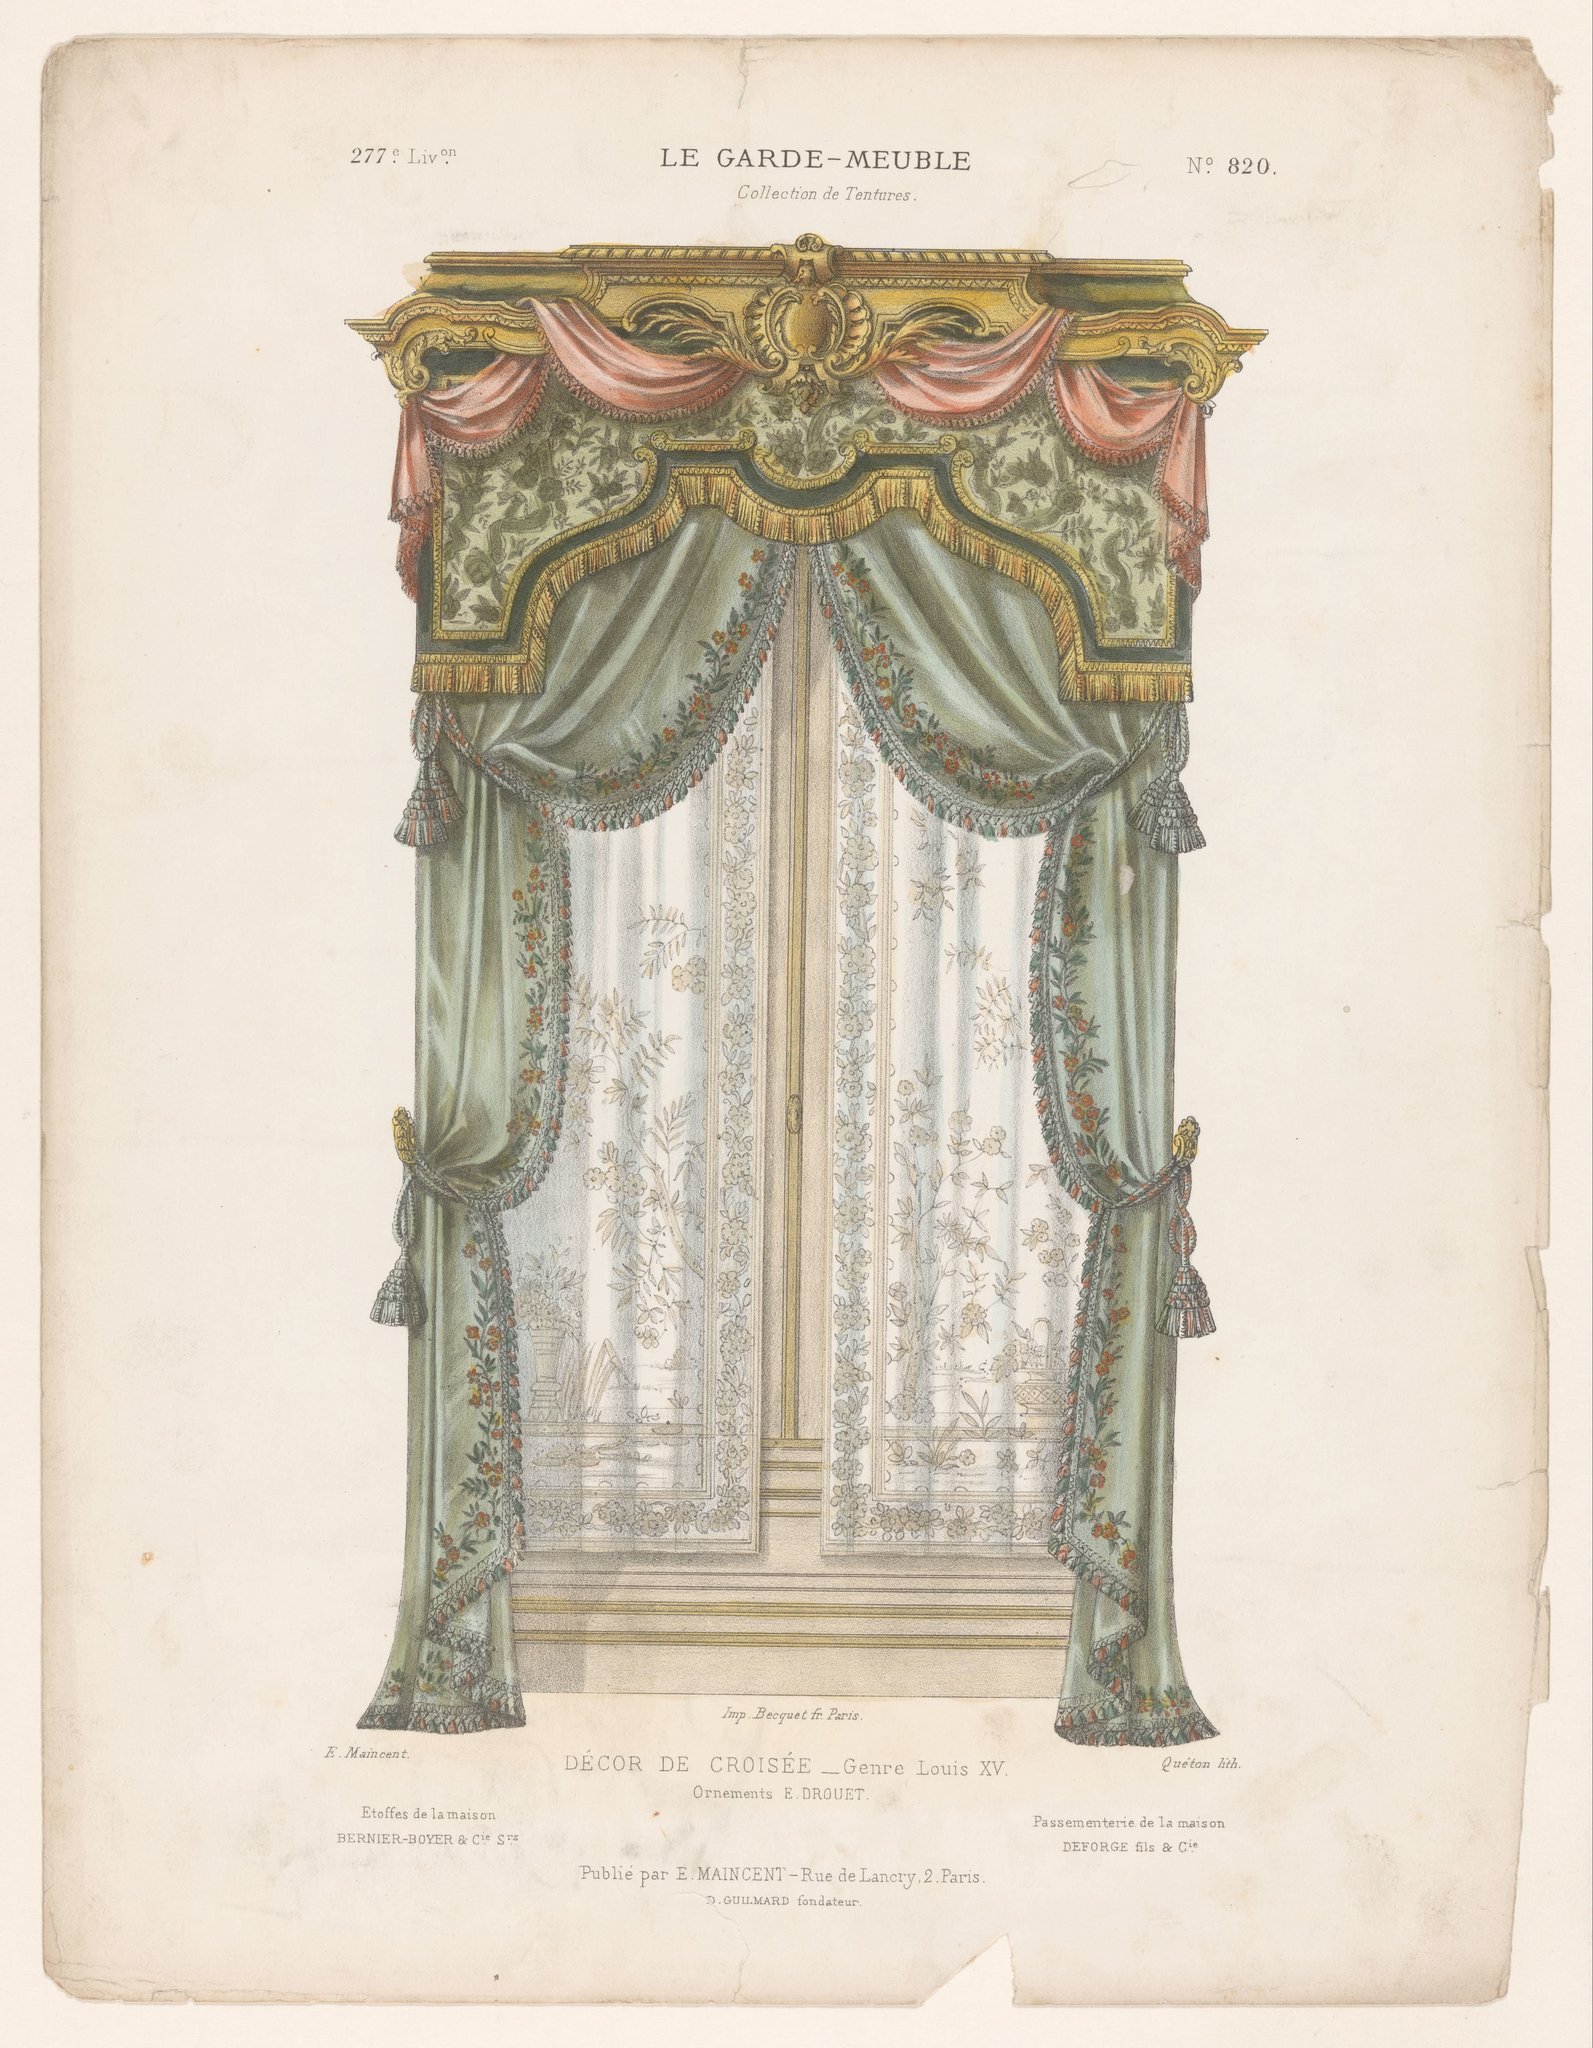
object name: print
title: Décor de Croisée - Genre Louis XV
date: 1885-1895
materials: paper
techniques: hand coloring, lithograph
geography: paris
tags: window, hangings and drapery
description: Kruisvenster met gedrapeerde gordijnen in de Lodewijk XV-stijl. Prent uit 277e Livraison.